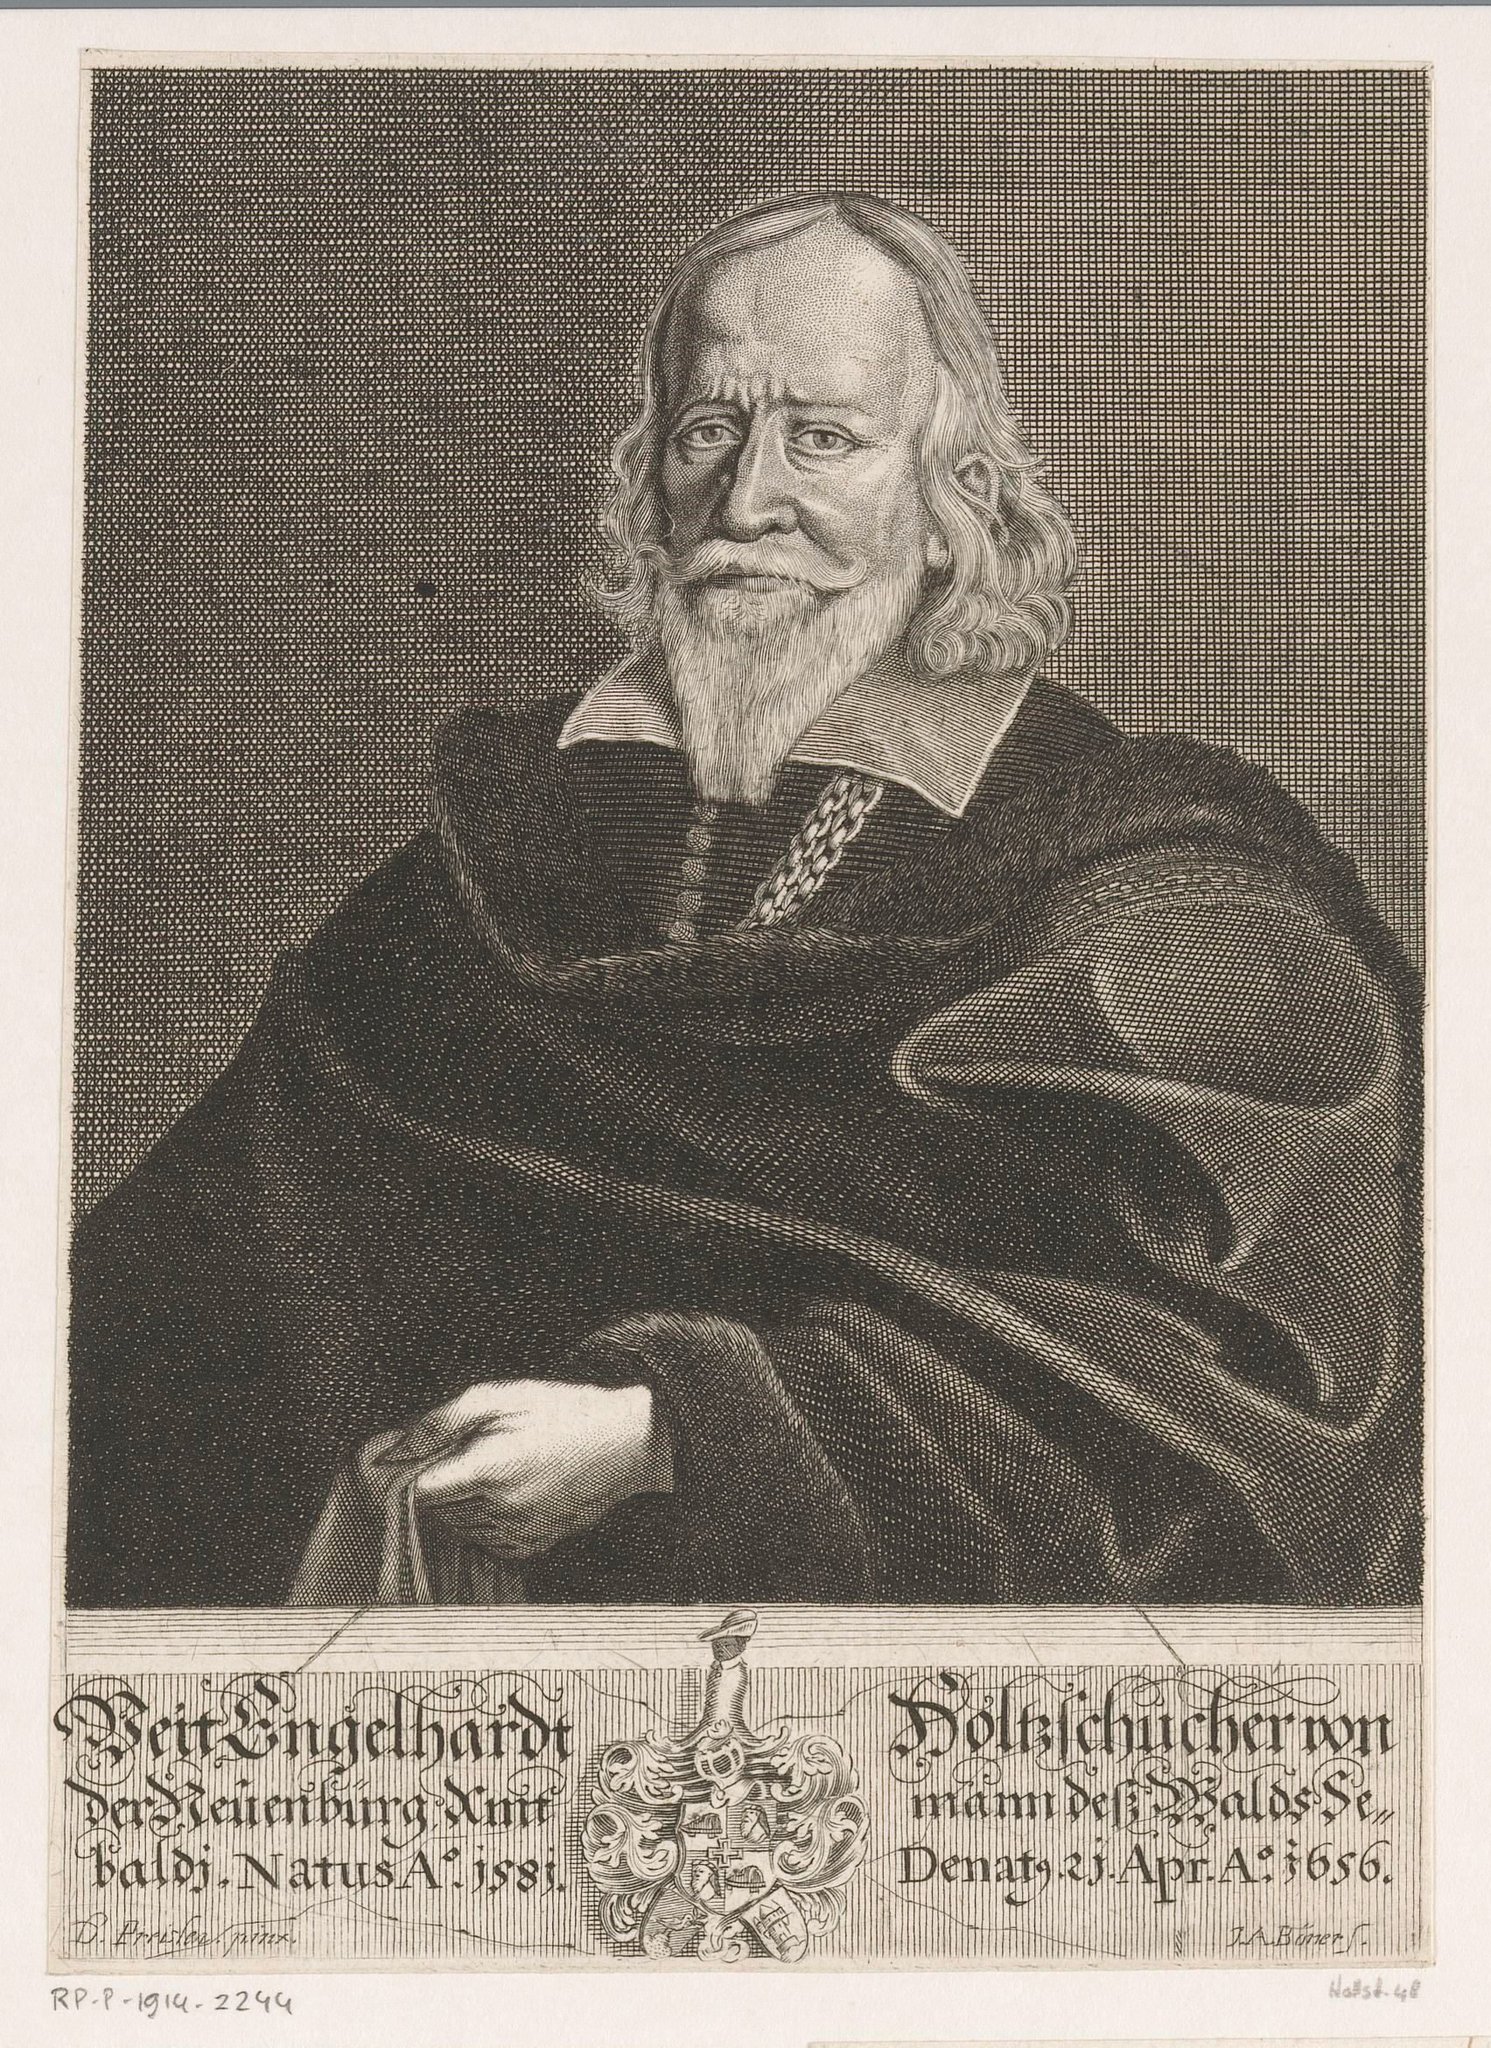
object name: print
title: Portret van Veit Engelhard Holzschuher von Neuenbürg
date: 1657-1720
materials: paper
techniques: engraving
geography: nuremberg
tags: historical persons, armorial bearing, heraldry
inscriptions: collector's mark: Lugt 2228